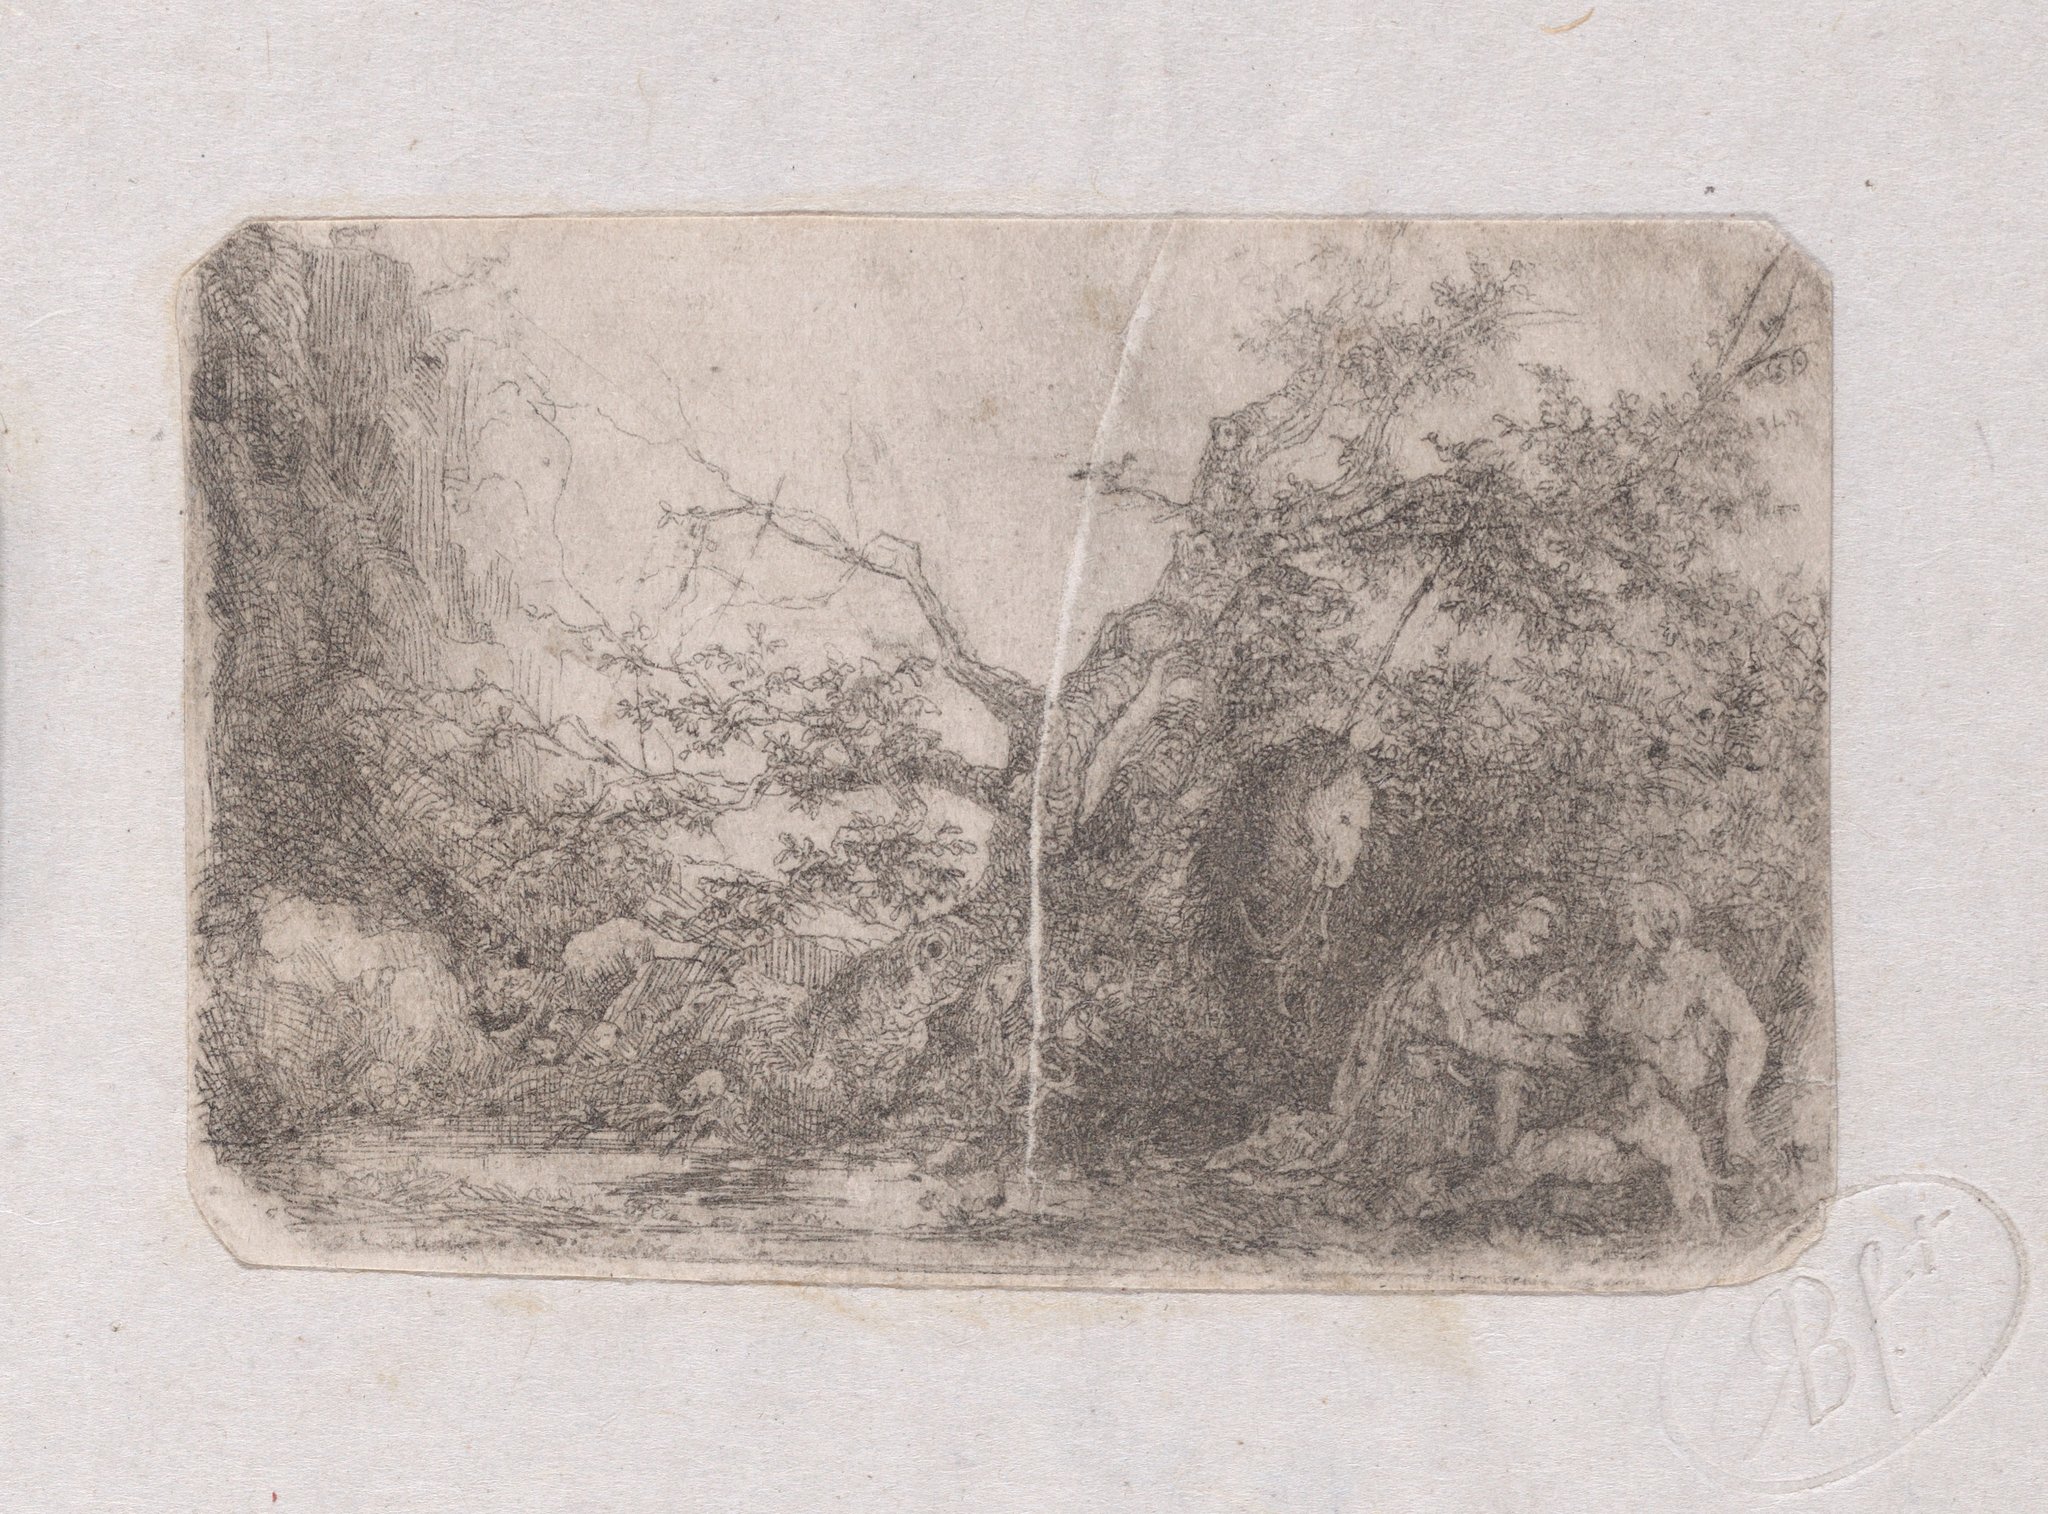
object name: print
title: Le Bon Samaritan (The Good Samaritan)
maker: rodolphe bresdin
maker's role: artist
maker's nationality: french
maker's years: 1822-1885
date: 1849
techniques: etching